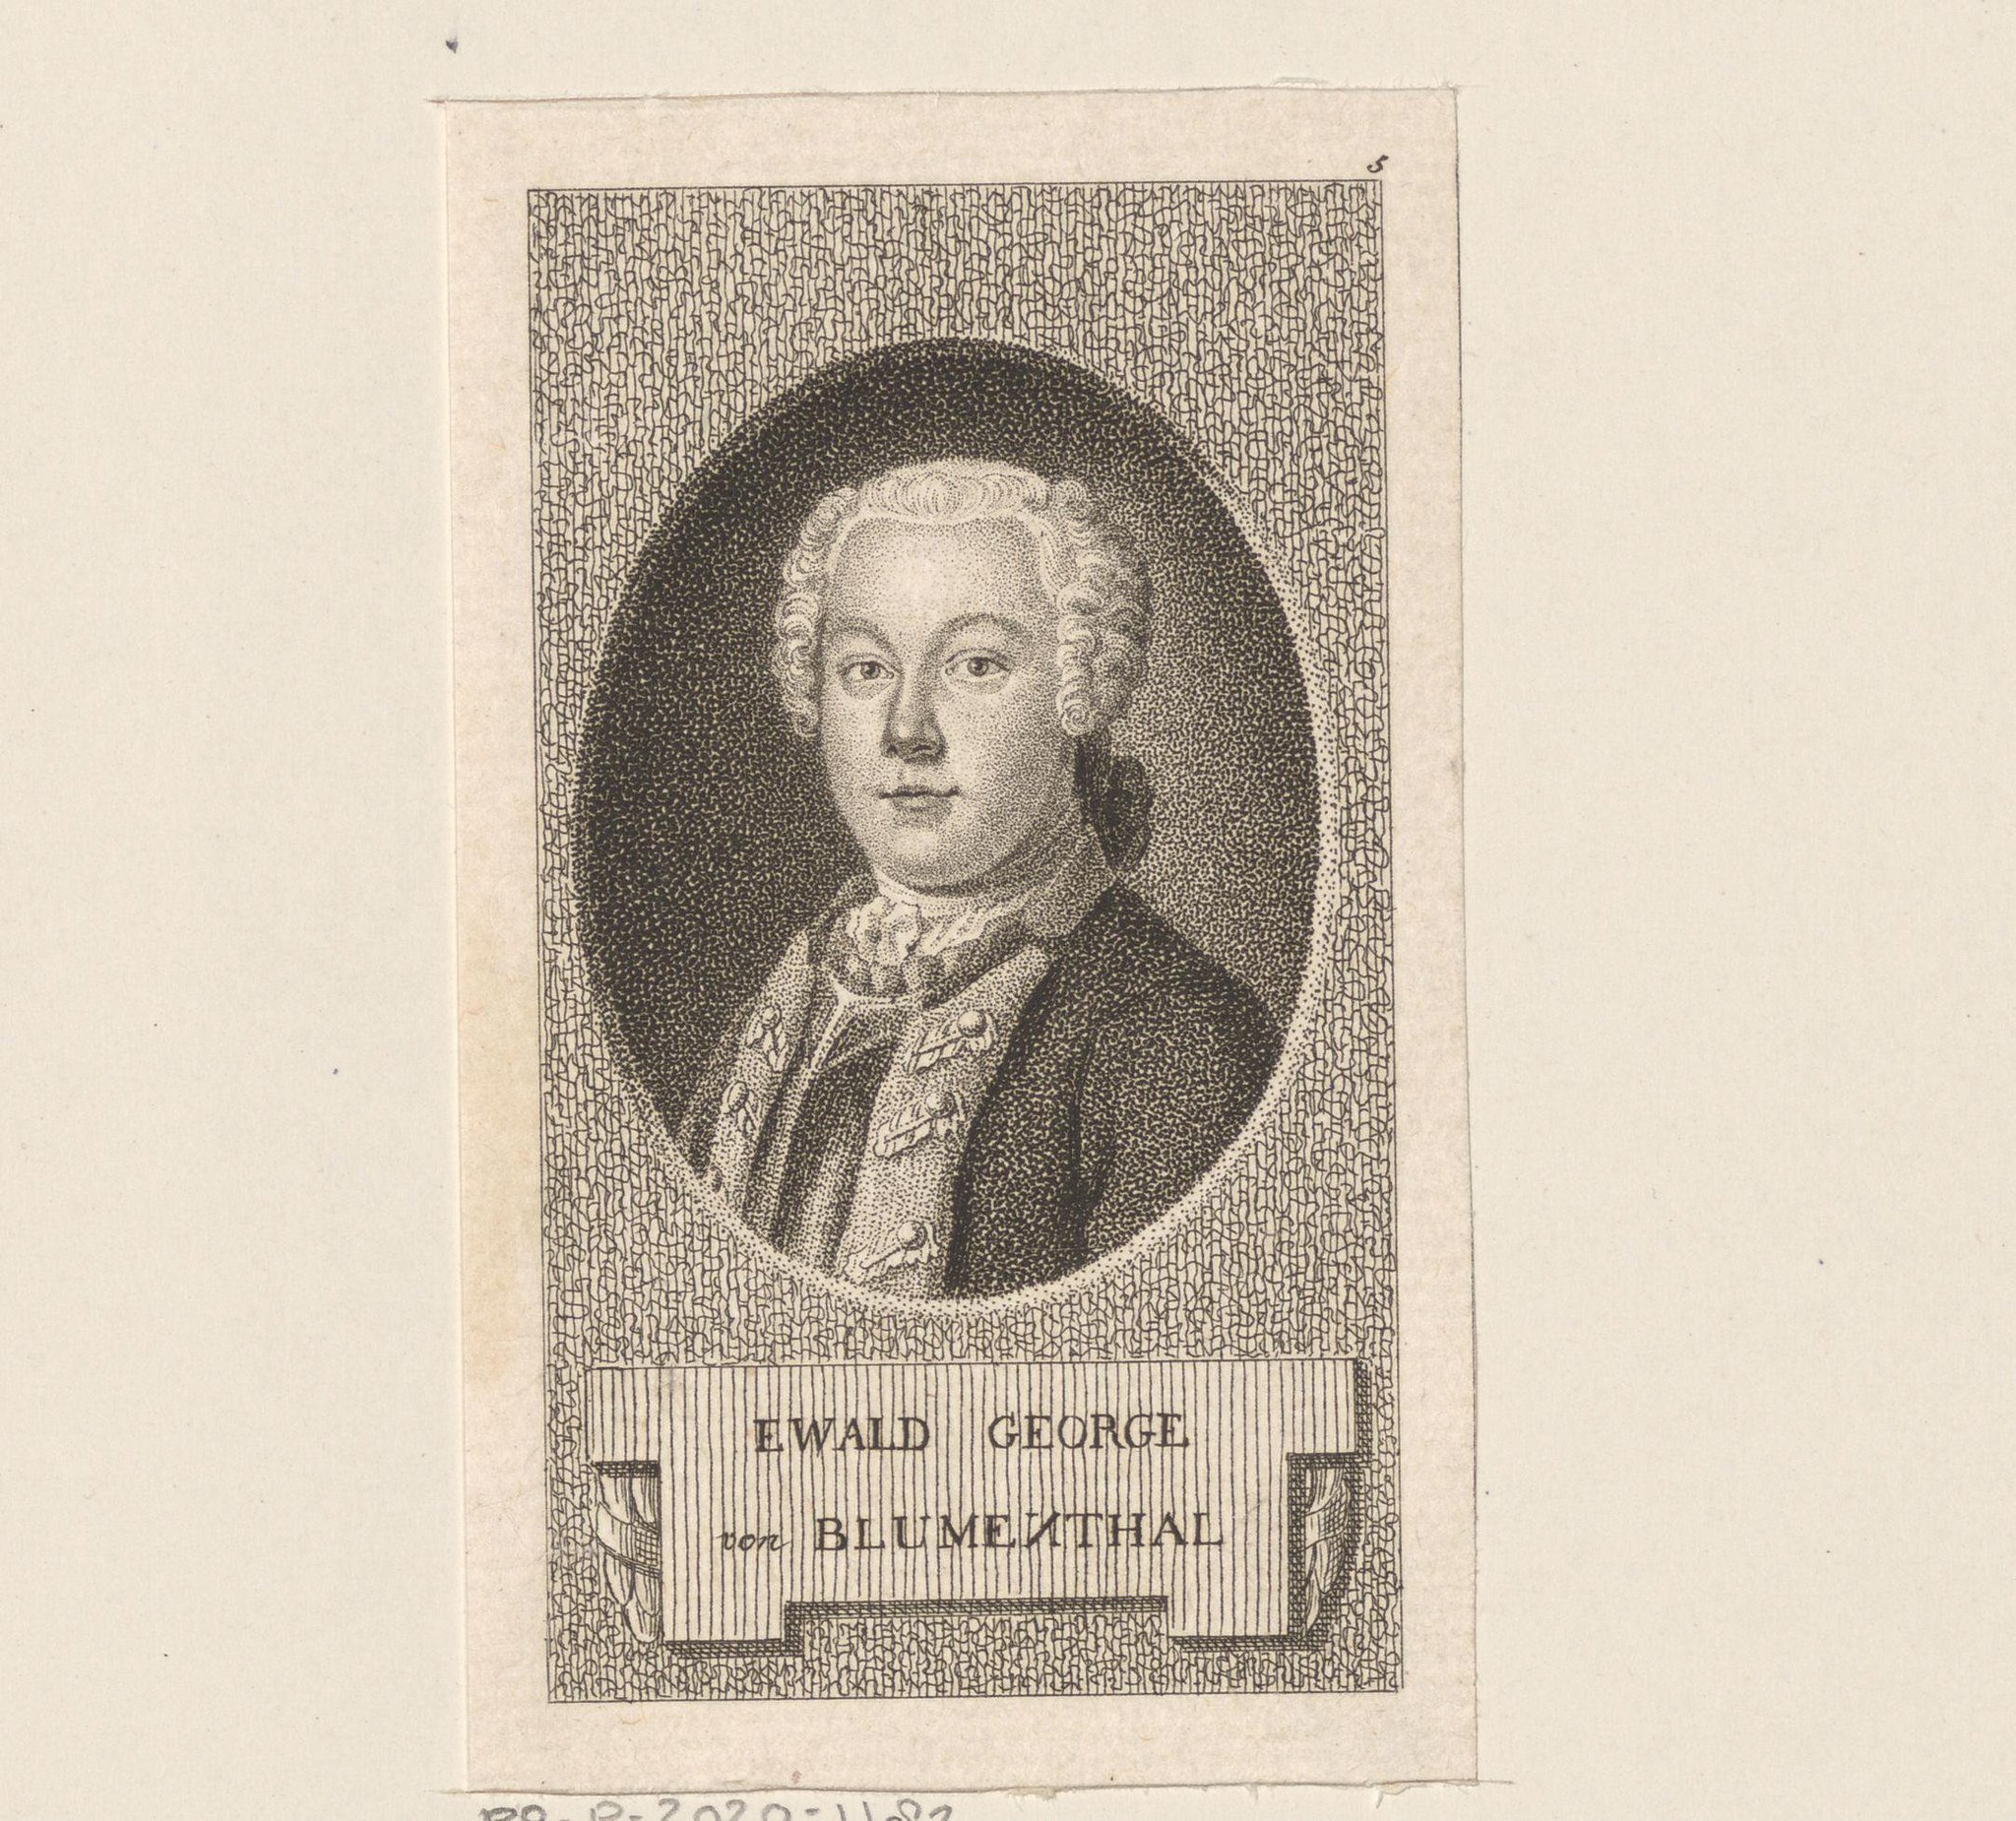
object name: print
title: Portret van Georg Ewald von Blumenthal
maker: Anonymous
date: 1750-1799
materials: paper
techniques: etching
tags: historical persons, officer